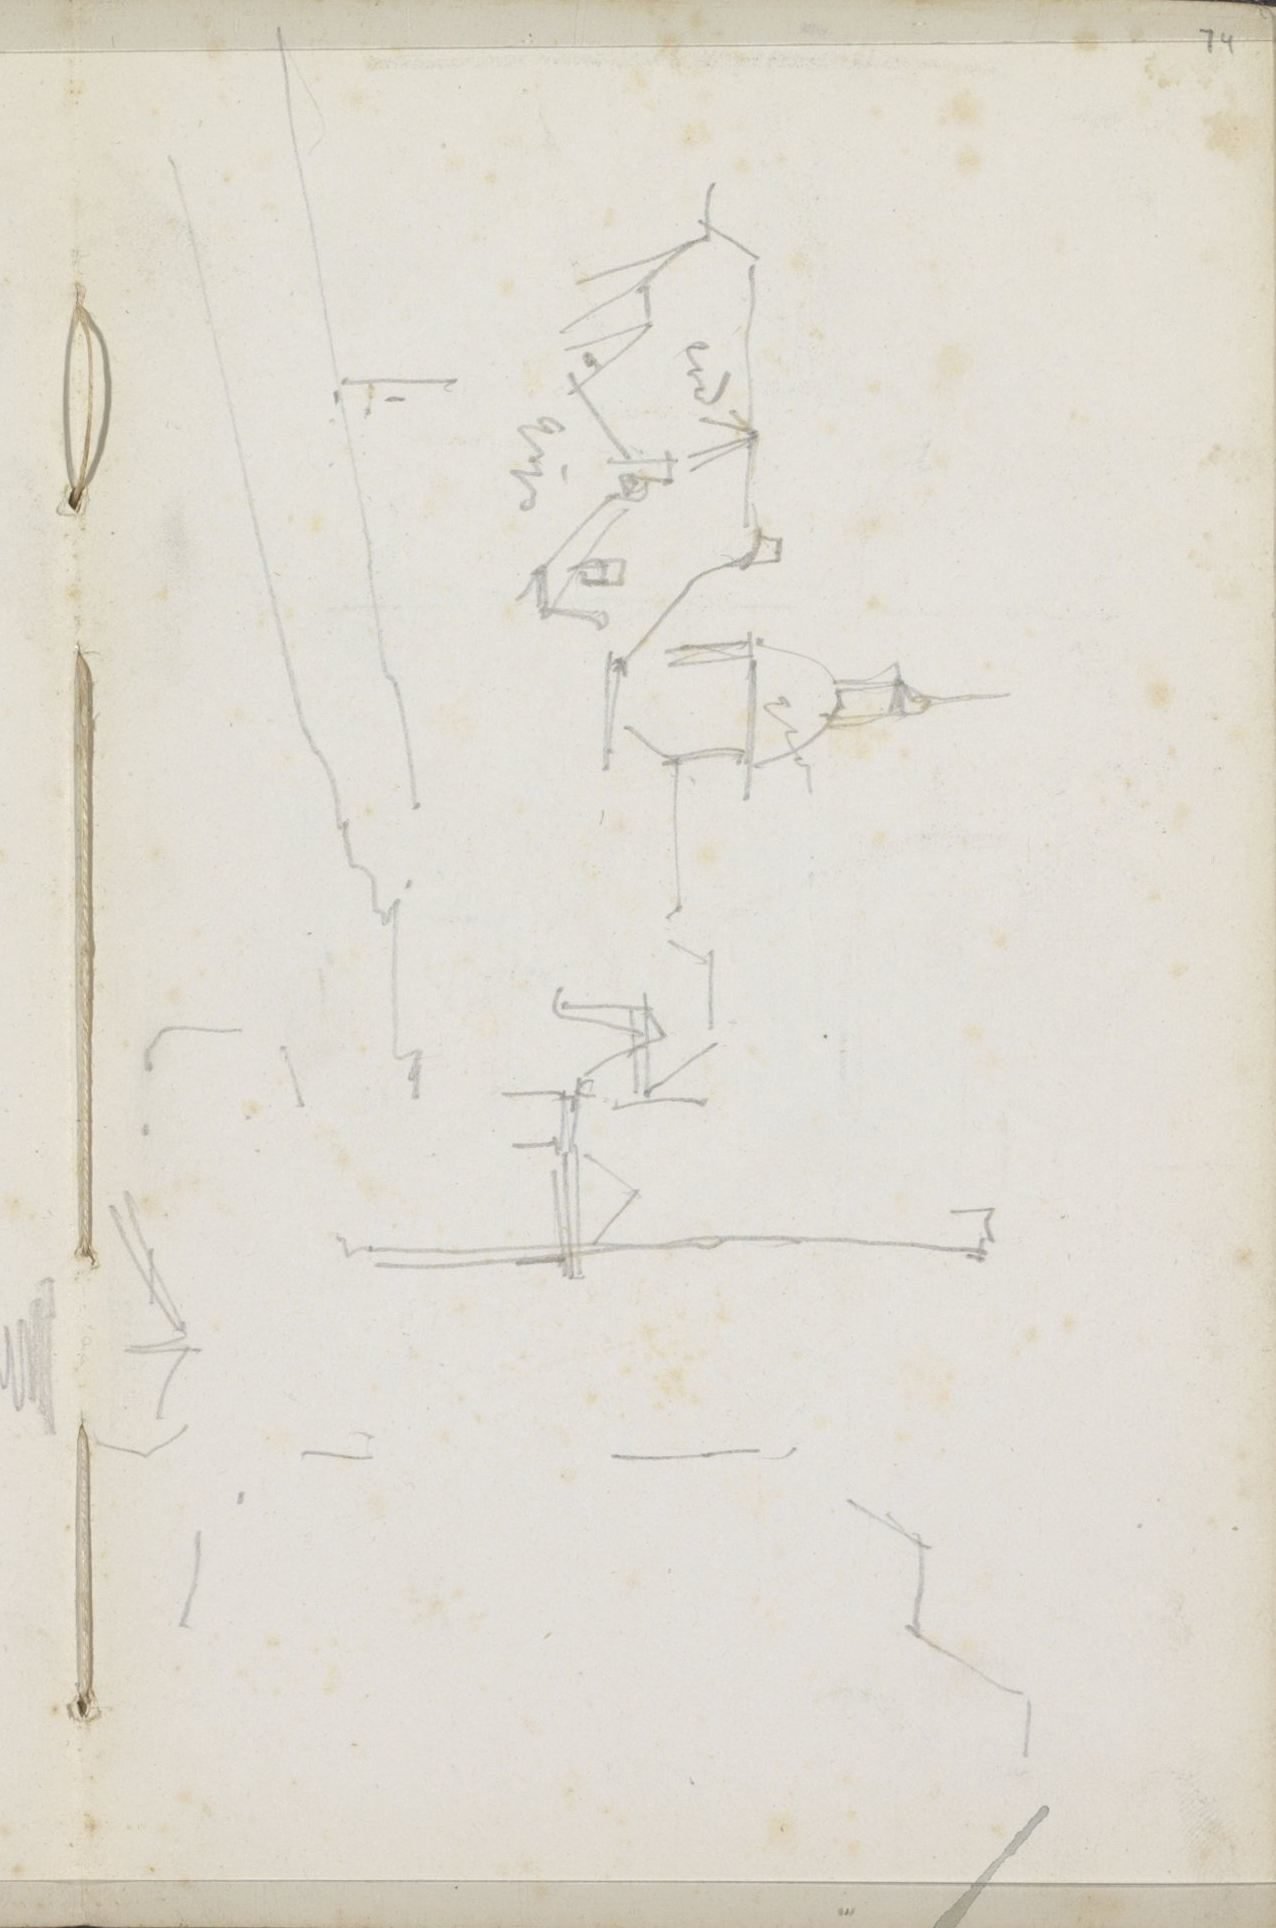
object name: sketchbook leaf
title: Stadsgezicht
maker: george hendrik breitner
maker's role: draughtsman, painter, print maker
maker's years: 1857-1923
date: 1880-1882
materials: paper, pencil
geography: gorinchem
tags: civic architecture; edifices; dwellings, street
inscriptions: kleurnotitie, handgeschreven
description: Mogelijk Gorinchem. Pagina 74 uit een schetsboek met 72 bladen.